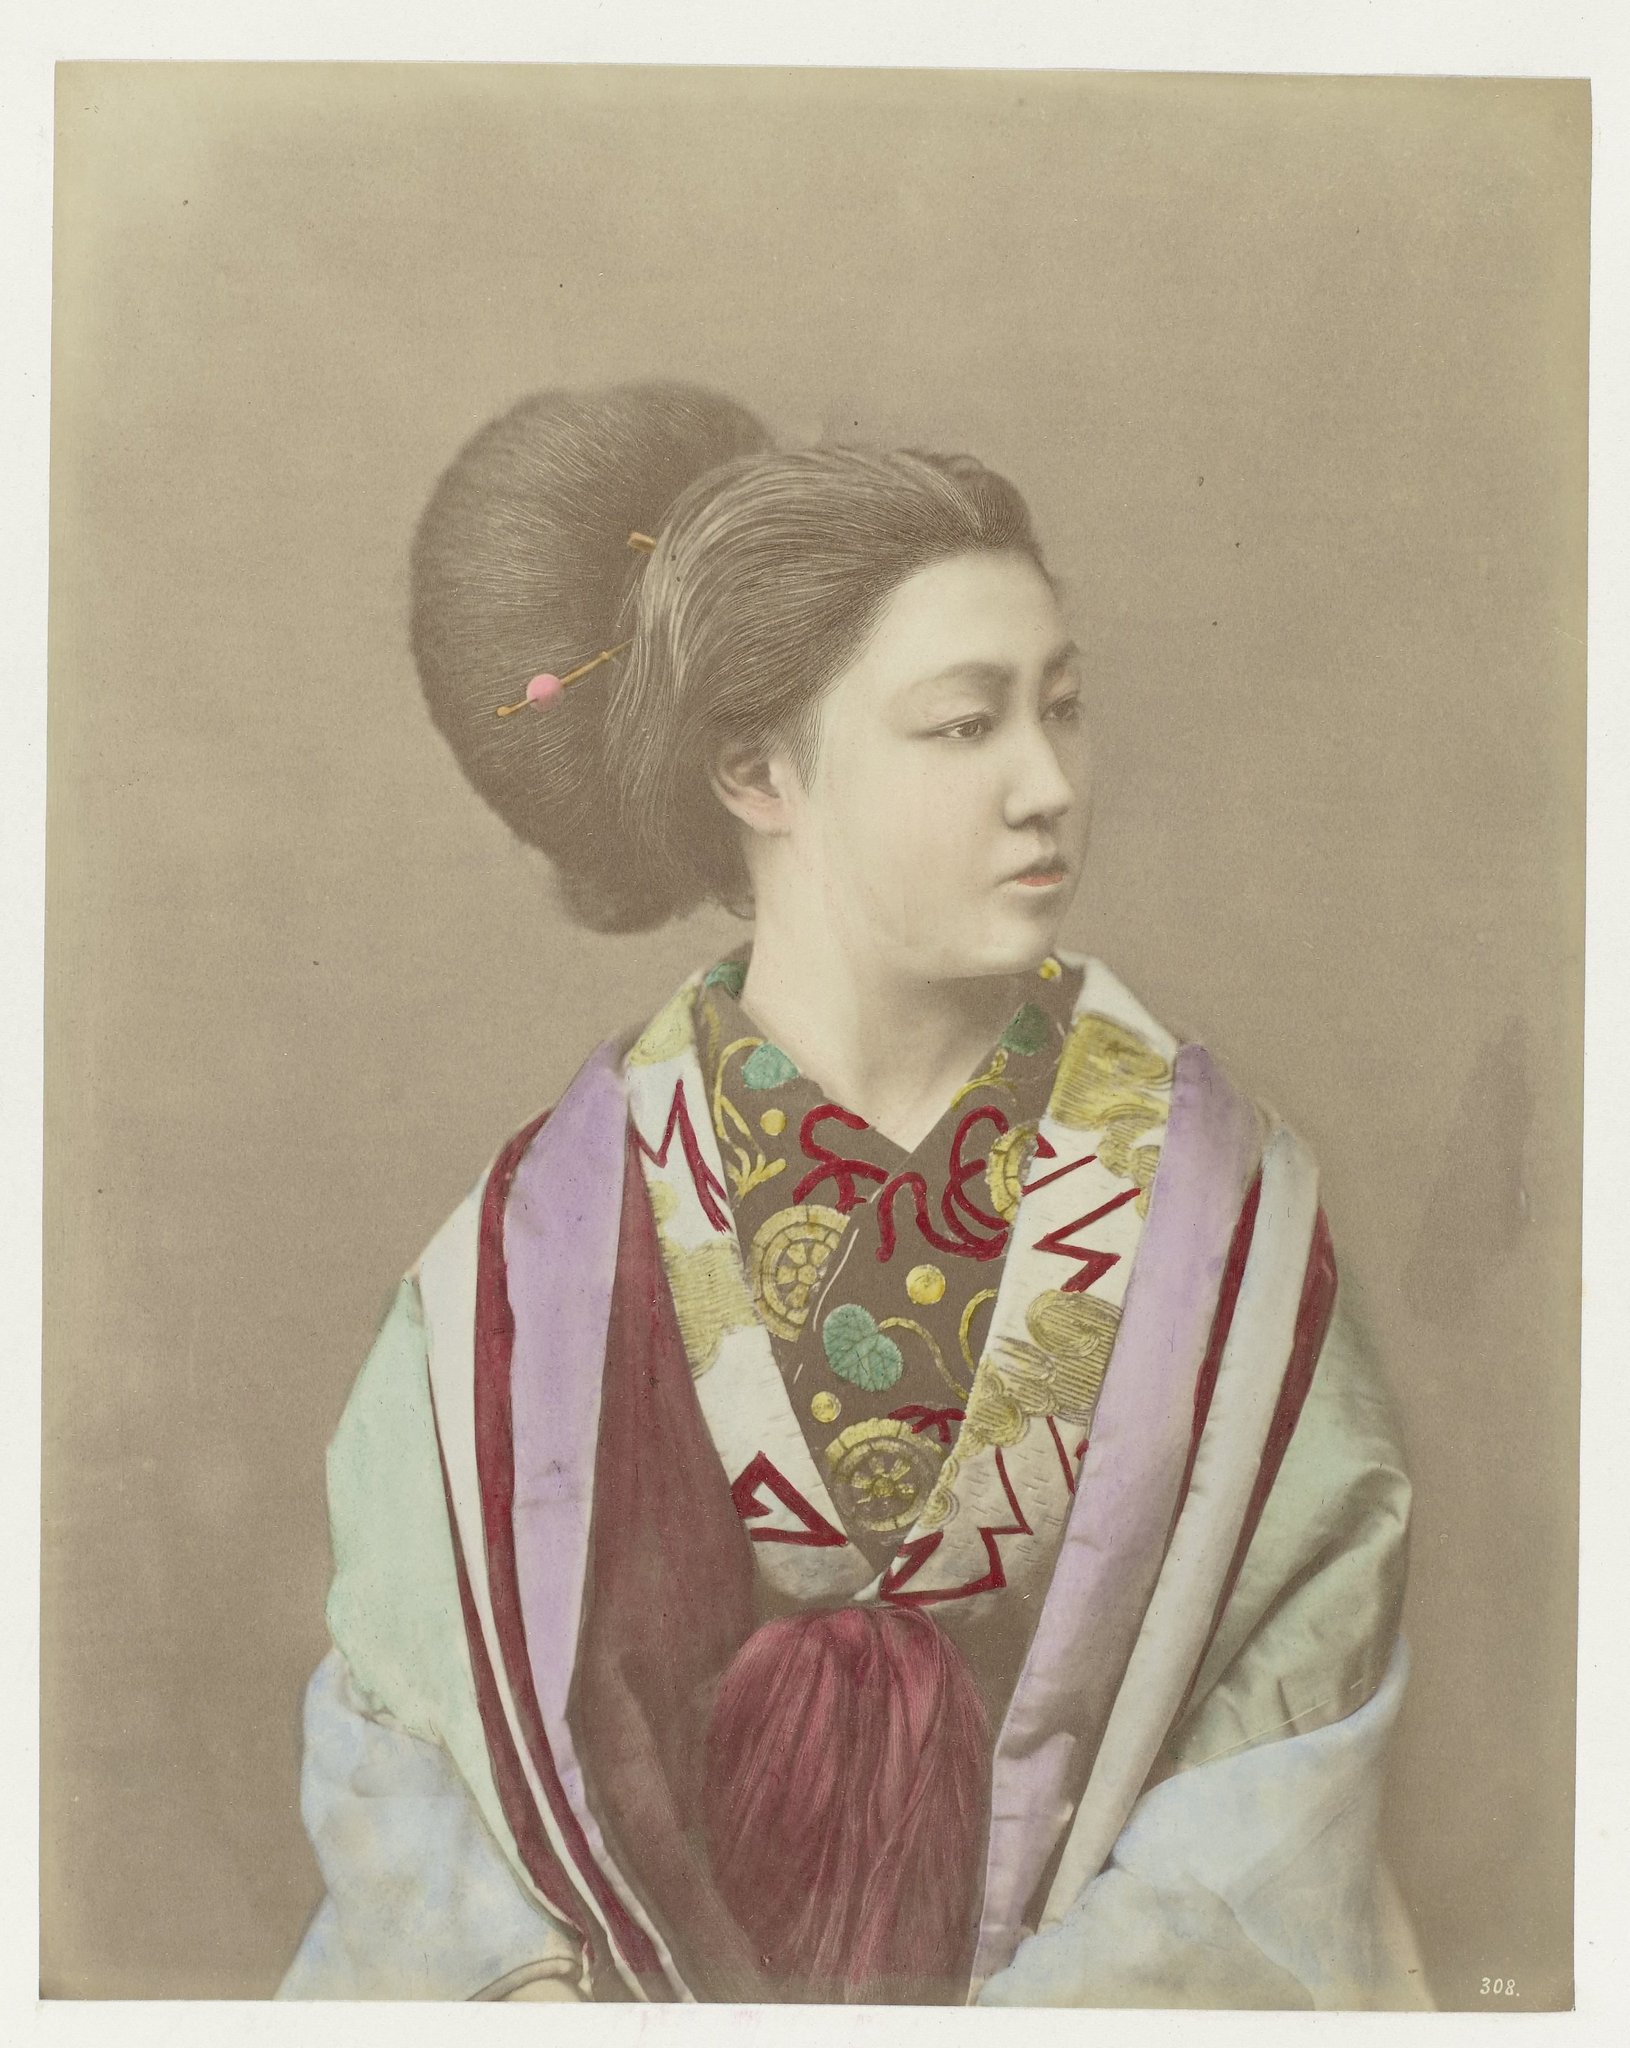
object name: photograph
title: Portret van een Japanse vrouw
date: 1860-1885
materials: cardboard, photographic support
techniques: albumen print, hand coloring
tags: adult woman, historical persons - bb - woman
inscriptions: number: ‘308’, annotation: ‘Stillfried of Beato’